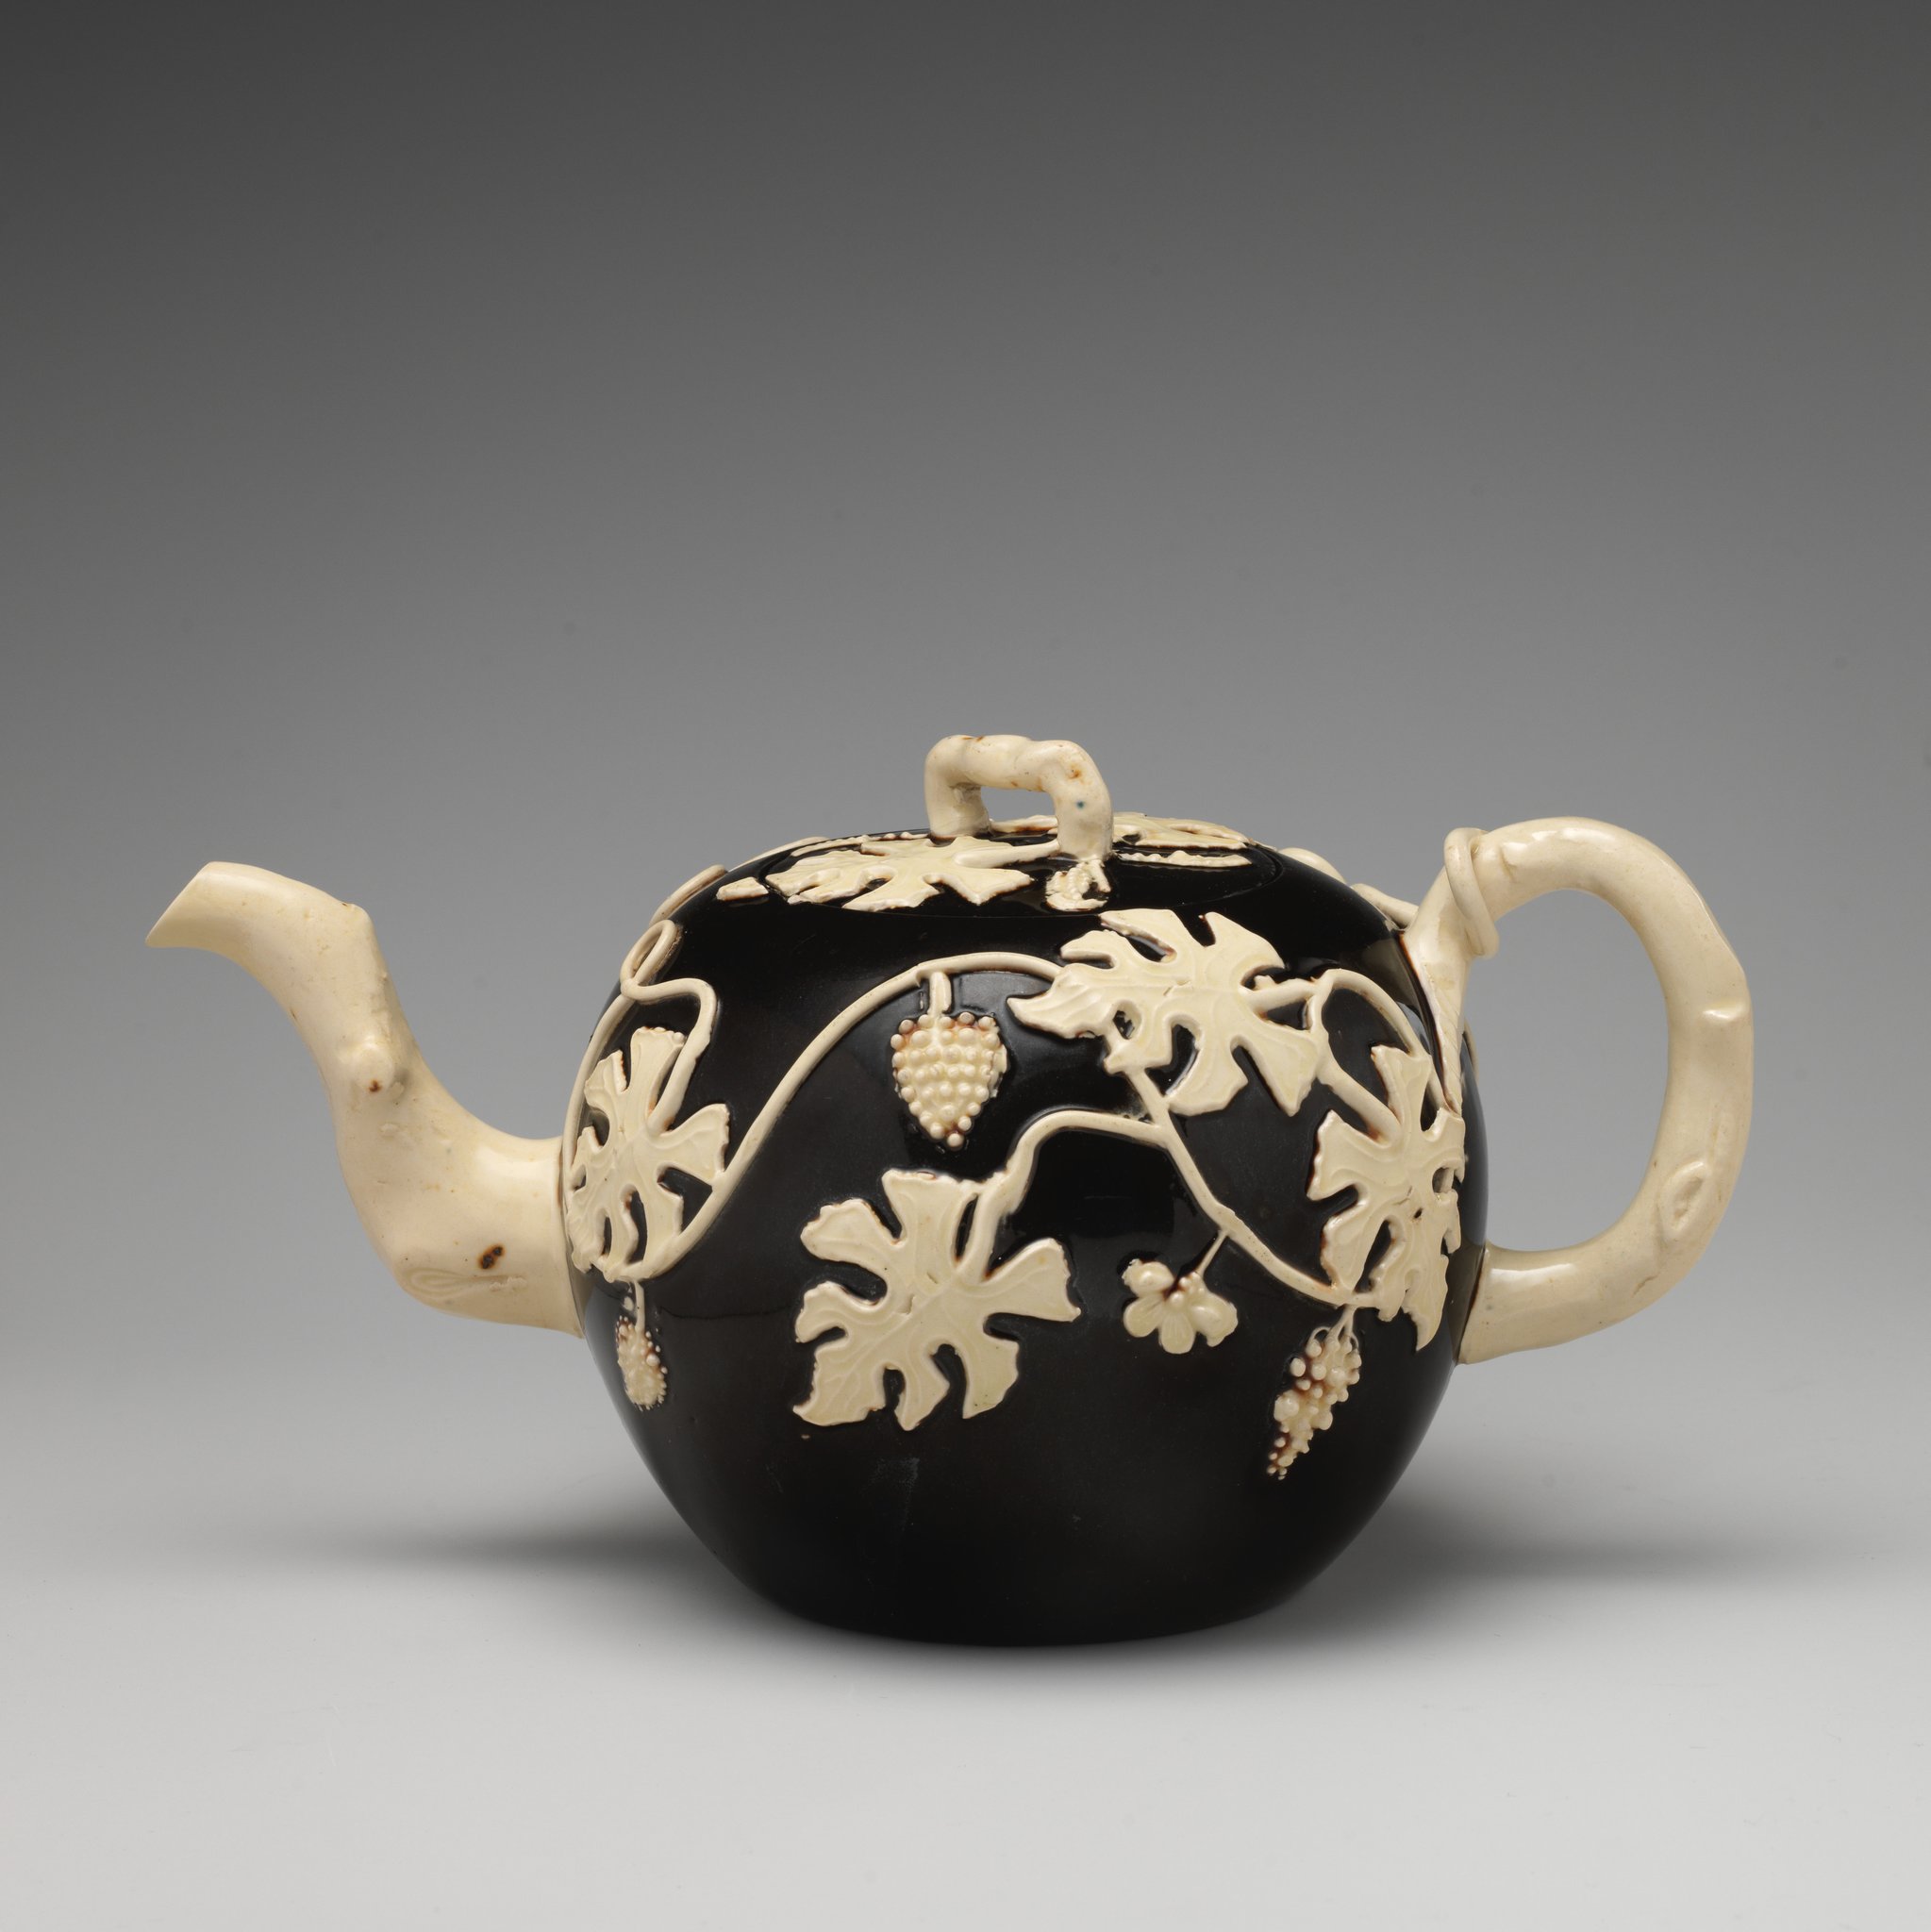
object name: teapot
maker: john astbury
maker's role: maker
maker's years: 1688-1743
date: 1740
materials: earthenware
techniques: glazing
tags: leaves,vines